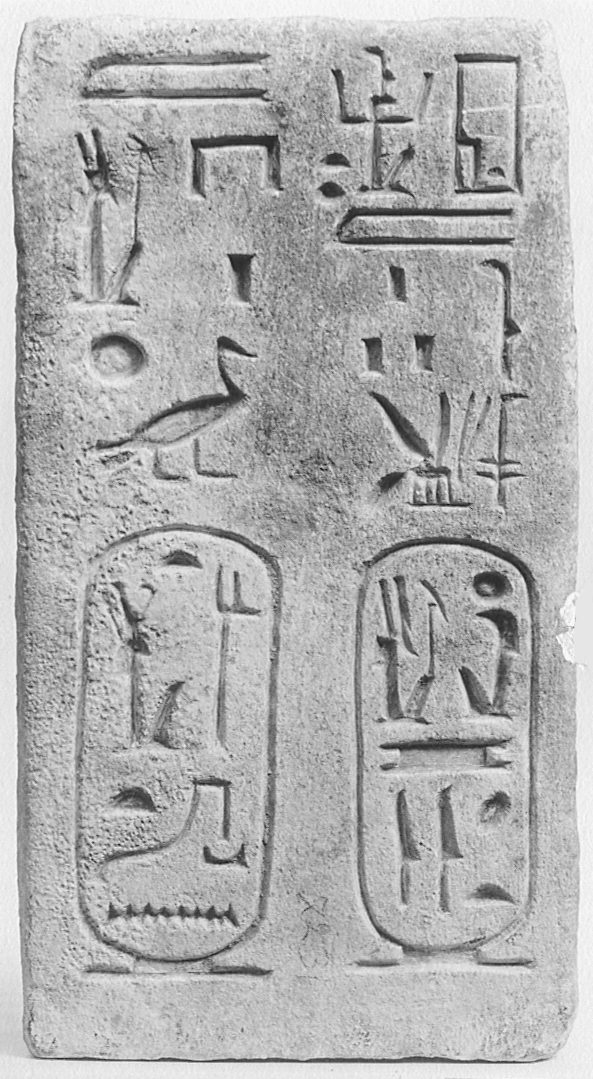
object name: brick, foundation deposit, tawosret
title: Brick with the Names of Tawosret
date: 1188-1186 BCE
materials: limestone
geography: upper egypt, thebes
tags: cartouches,hieroglyphs